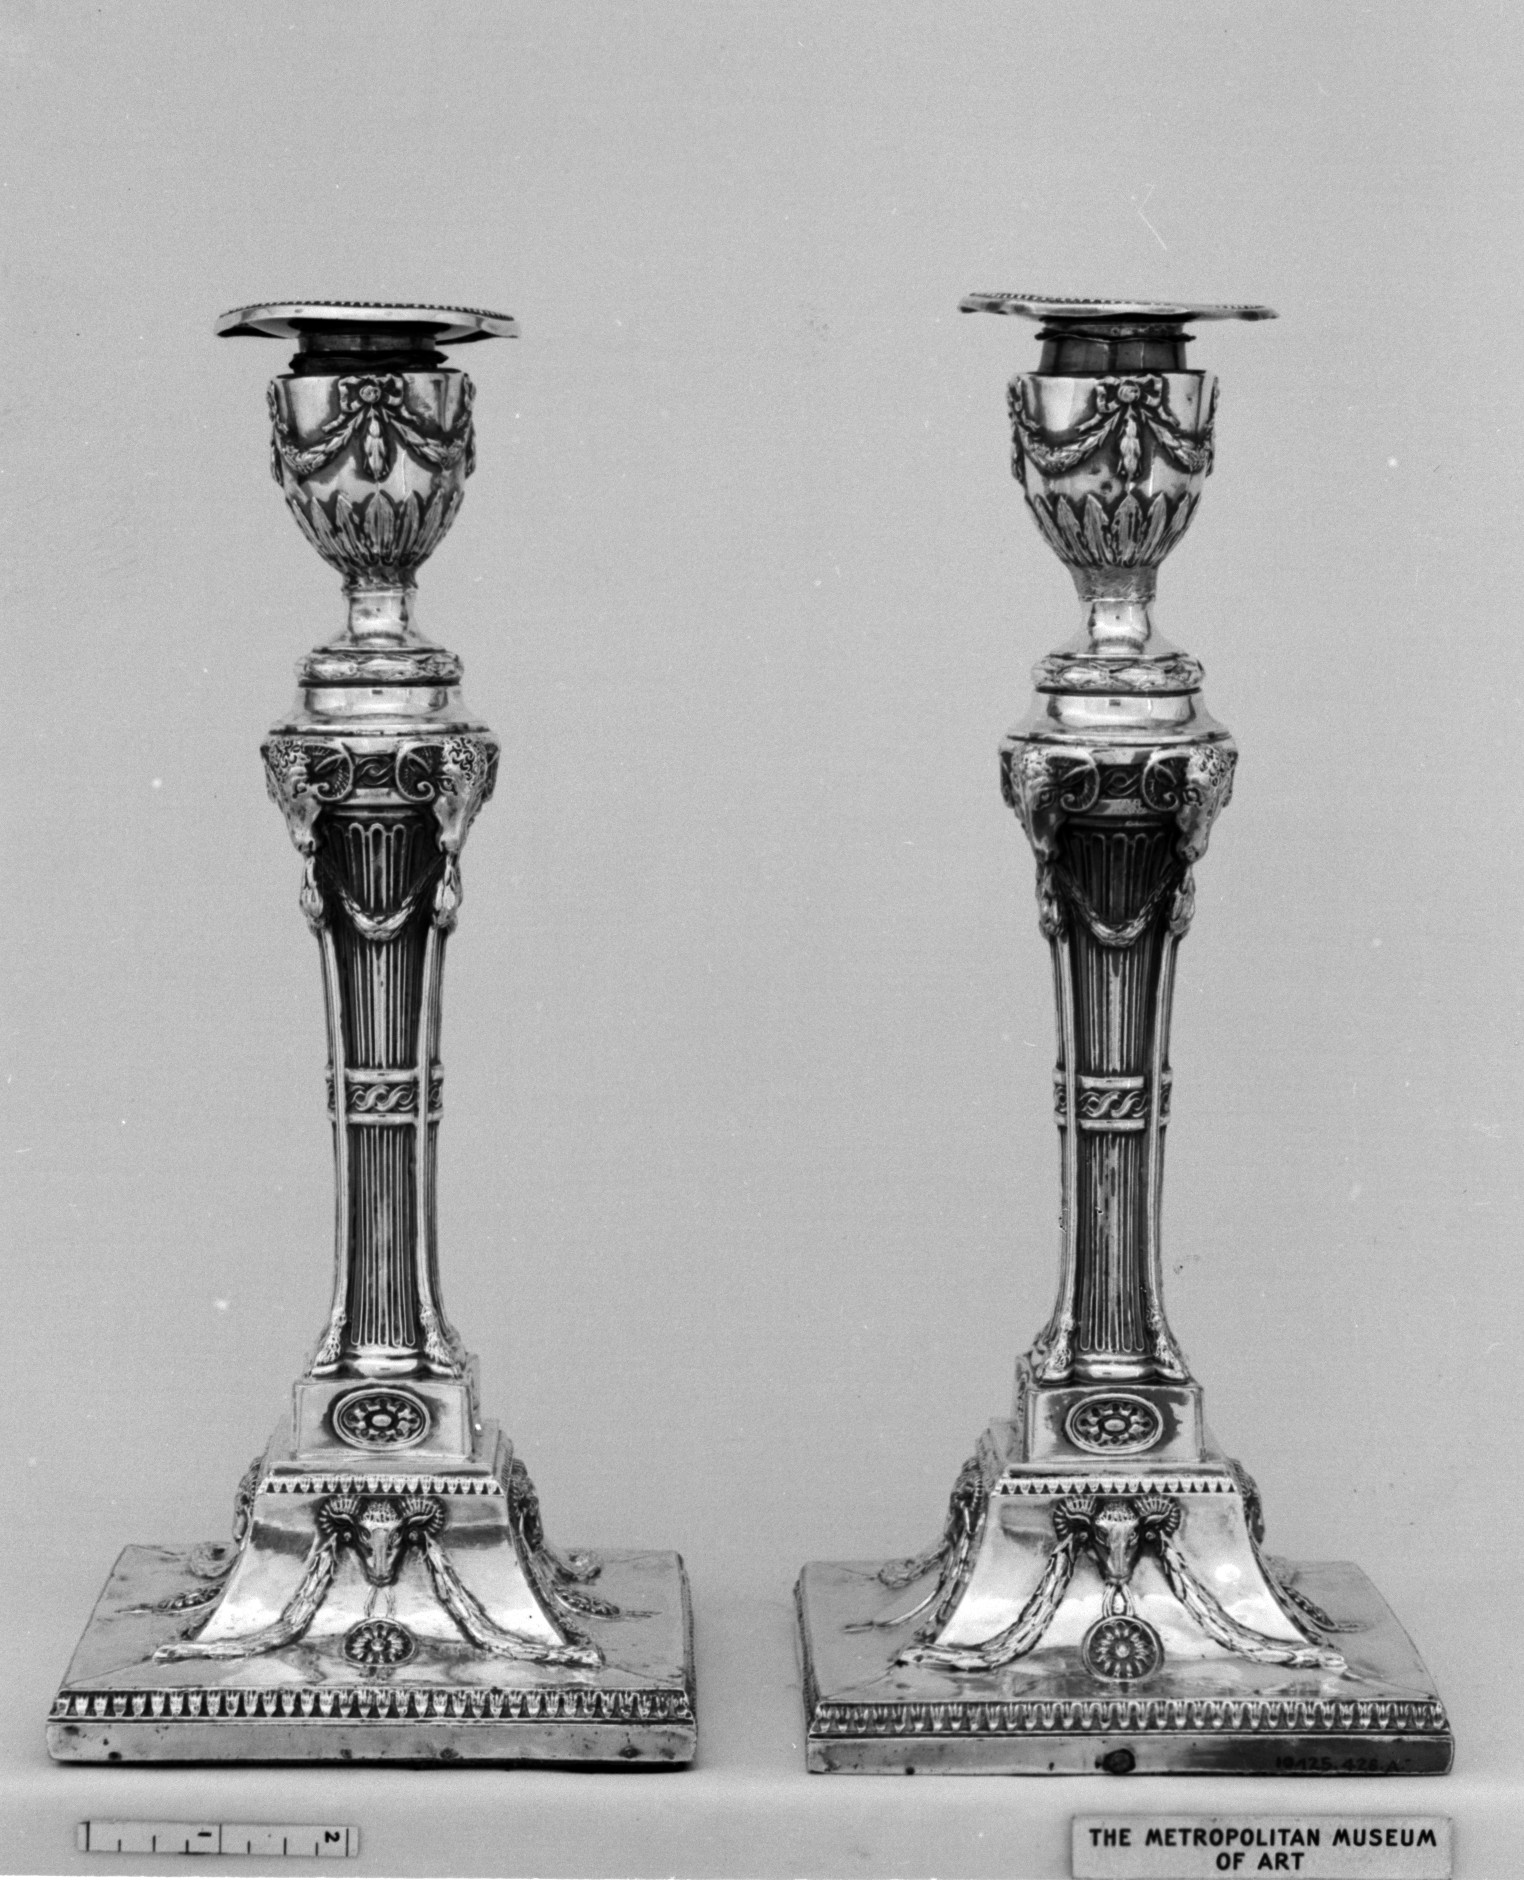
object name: candlestick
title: Pair of candlesticks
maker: john winter and co.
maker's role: maker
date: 1777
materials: metal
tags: buffalos